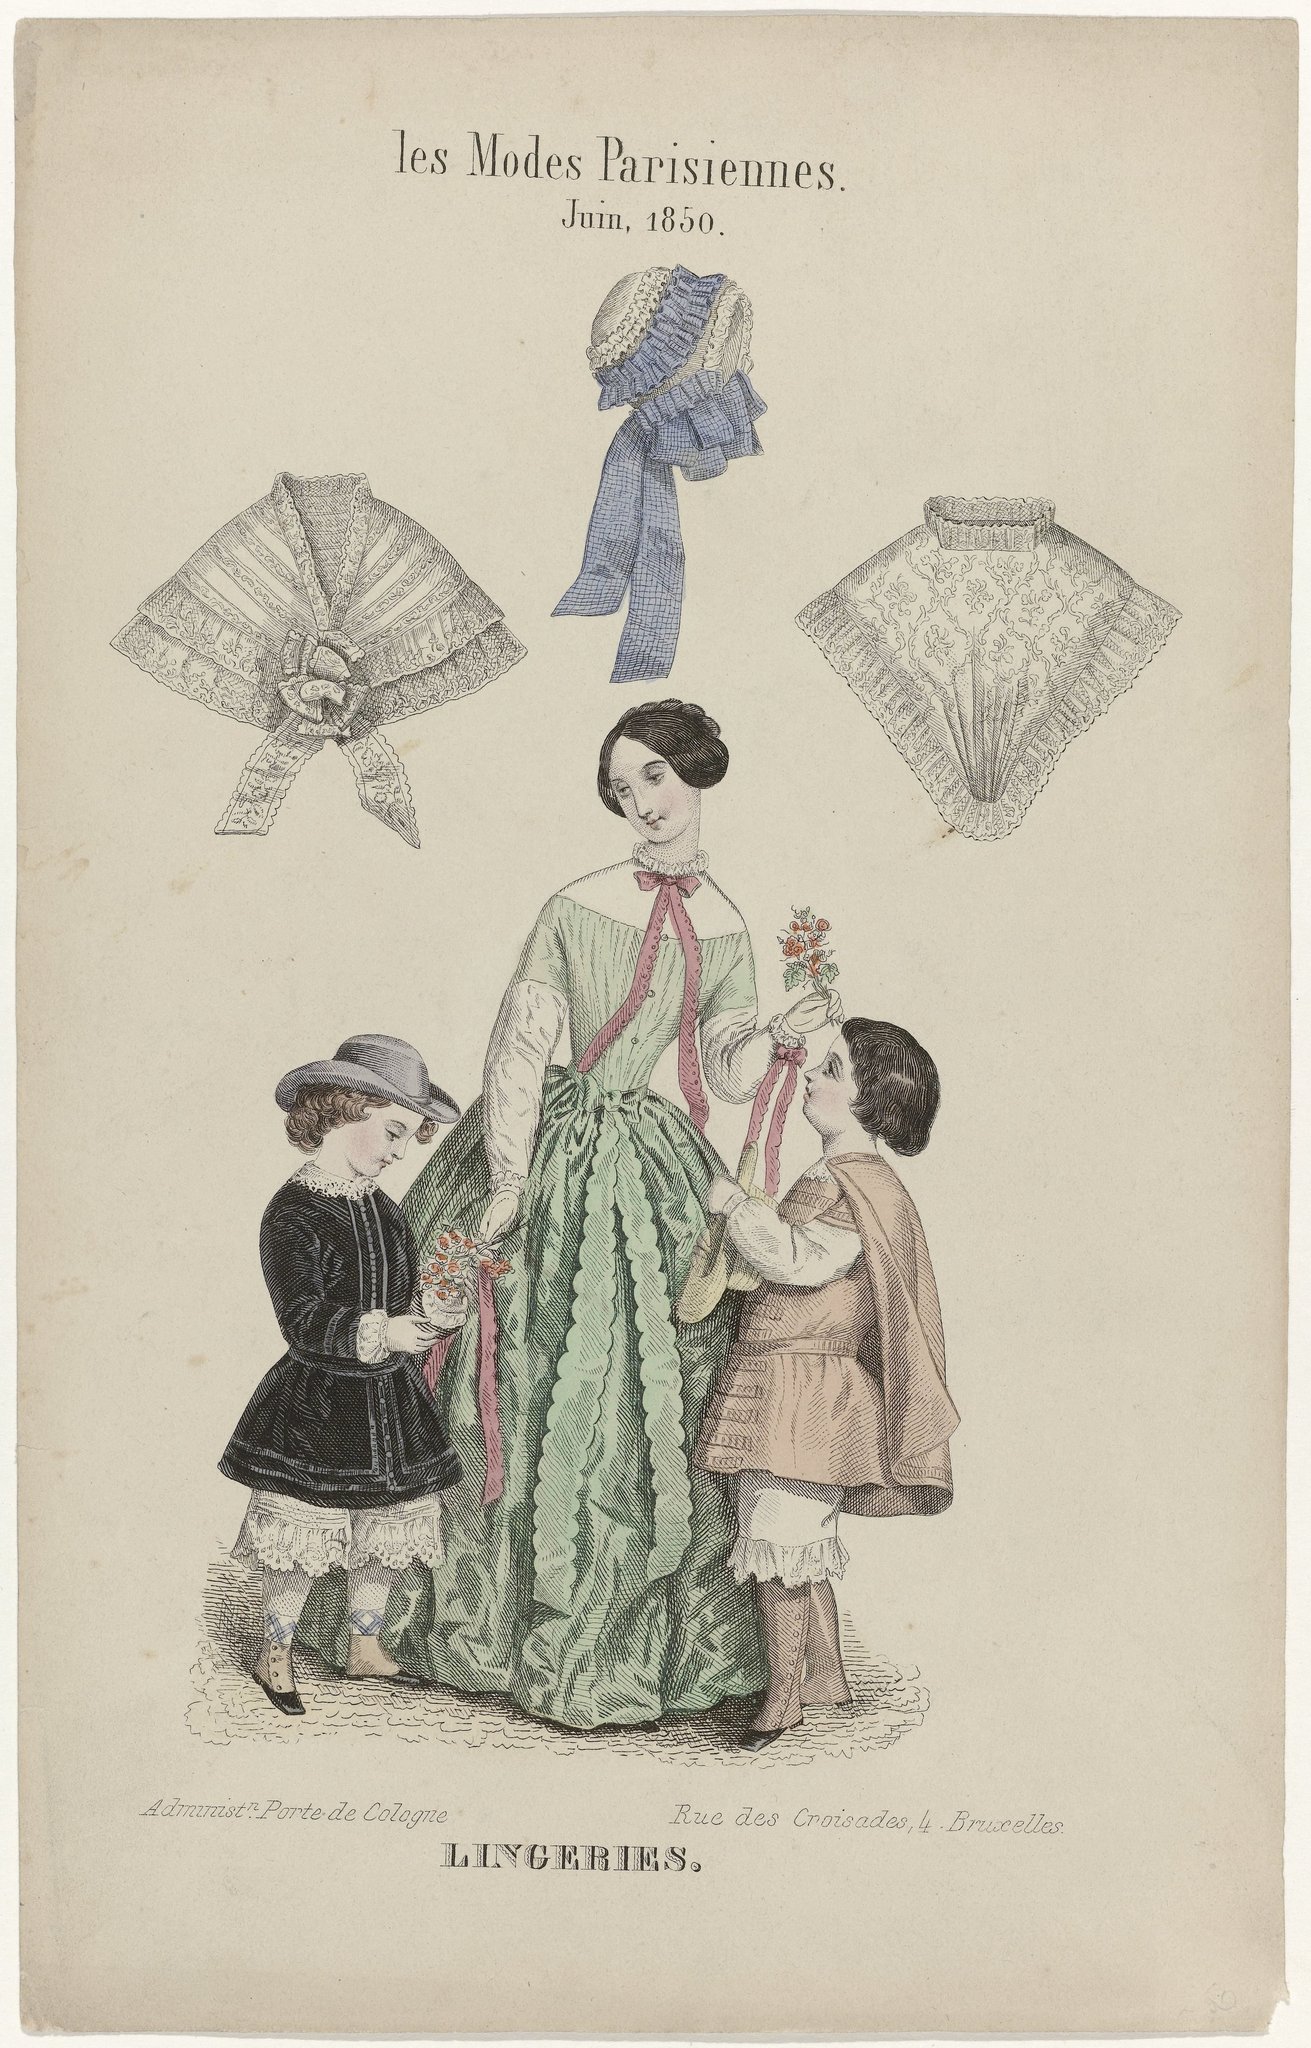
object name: fashion print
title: Les Modes Parisiennes, juin 1850 : Lingeries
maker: Anonymous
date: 1850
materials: paper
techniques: etching, hand coloring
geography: paris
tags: cut flowers; nosegay, bunch of flowers, piece of clothing covering the breast or décolleté (chemisette) (+ women's clothes), underclothes for the lower part of the body: bloomers (+ boys' clothes), clothes, costume (+ boys' clothes), cape (+ boys' clothes), head-gear: cap (+ women's clothes), fashion plates, dress, gown (+ women's clothes)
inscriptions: address: ‘Administ.n Porte de Cologne / Rue des Croisades, 4. Bruxelles.’, title: ‘Les Modes Parisiennes. / Juin, 1850.’, caption: ‘Lingeries.’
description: Een vrouw met twee kinderen,. Boven hen zijn een muts en twee chemisettes afgebeeld. Prent uit het modetijdschrift Les Modes Parisiennes (1843-1885).